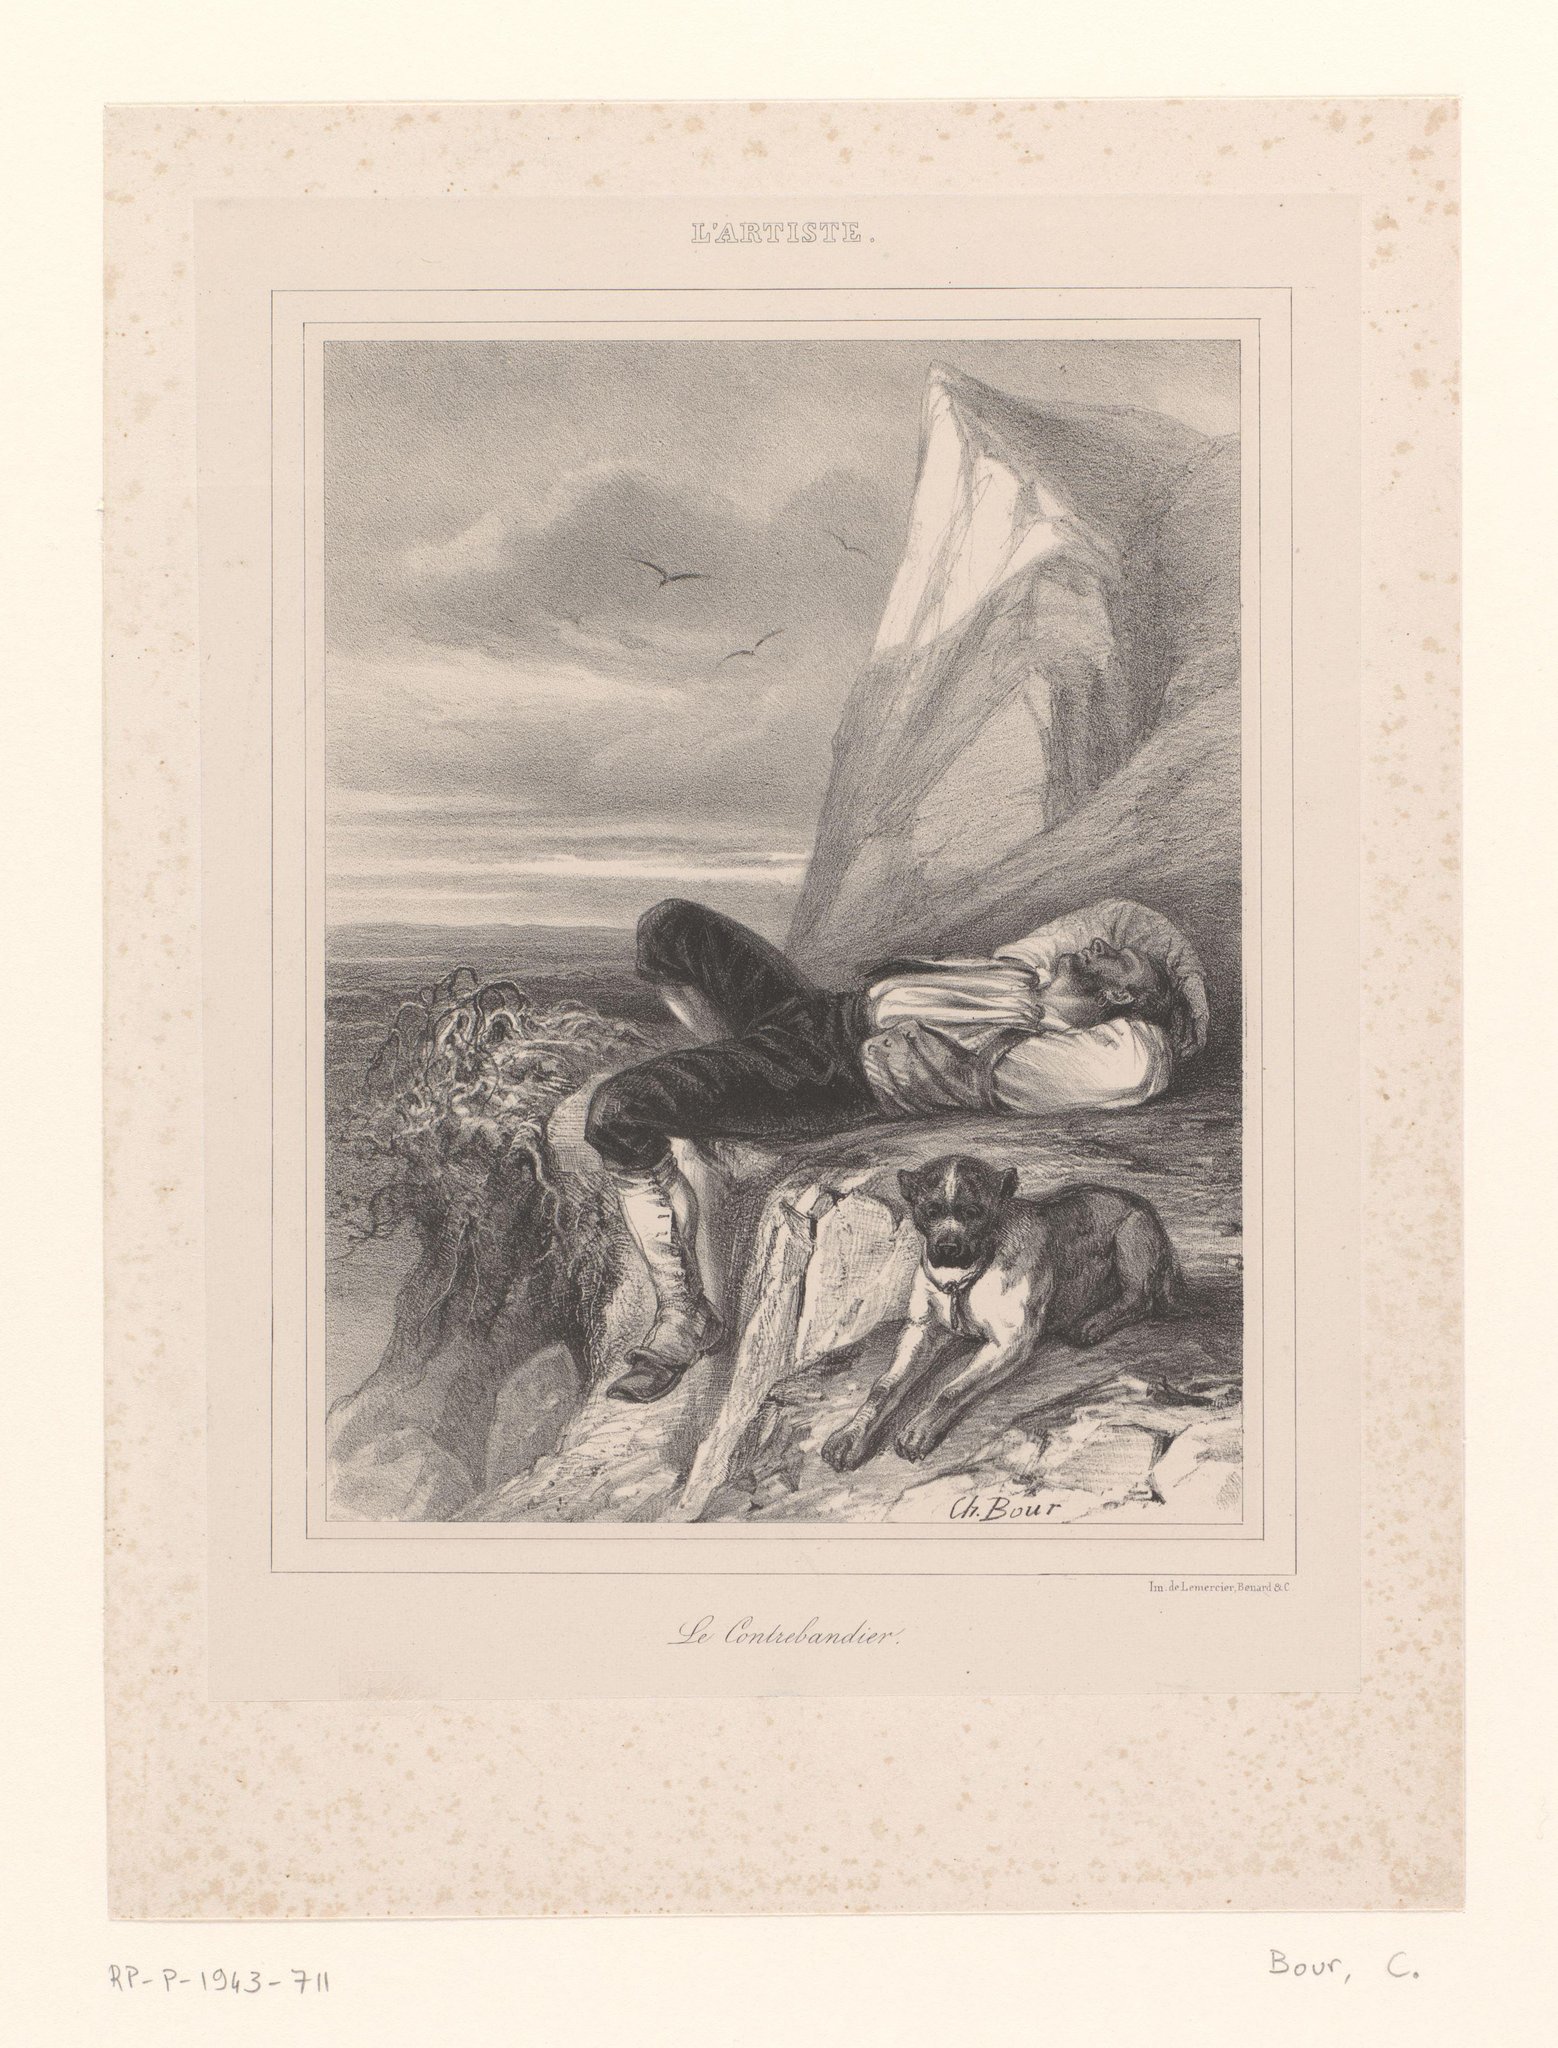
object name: print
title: Smokkelaar met hond rust op een rots bij de zee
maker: charles bour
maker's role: print maker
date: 1839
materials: paper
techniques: lithograph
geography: lunéville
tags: rocky coast, sleeping on the ground - bb - out of doors, smuggler, dog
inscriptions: collector's mark: Lugt 2228a, check stamp: Lugt 36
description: Prent gepubliceerd in het geïllustreerde weekblad 'L’Artiste, journal de la littérature et des beaux-arts', dat werd uitgegeven tussen 1831 en 1904.